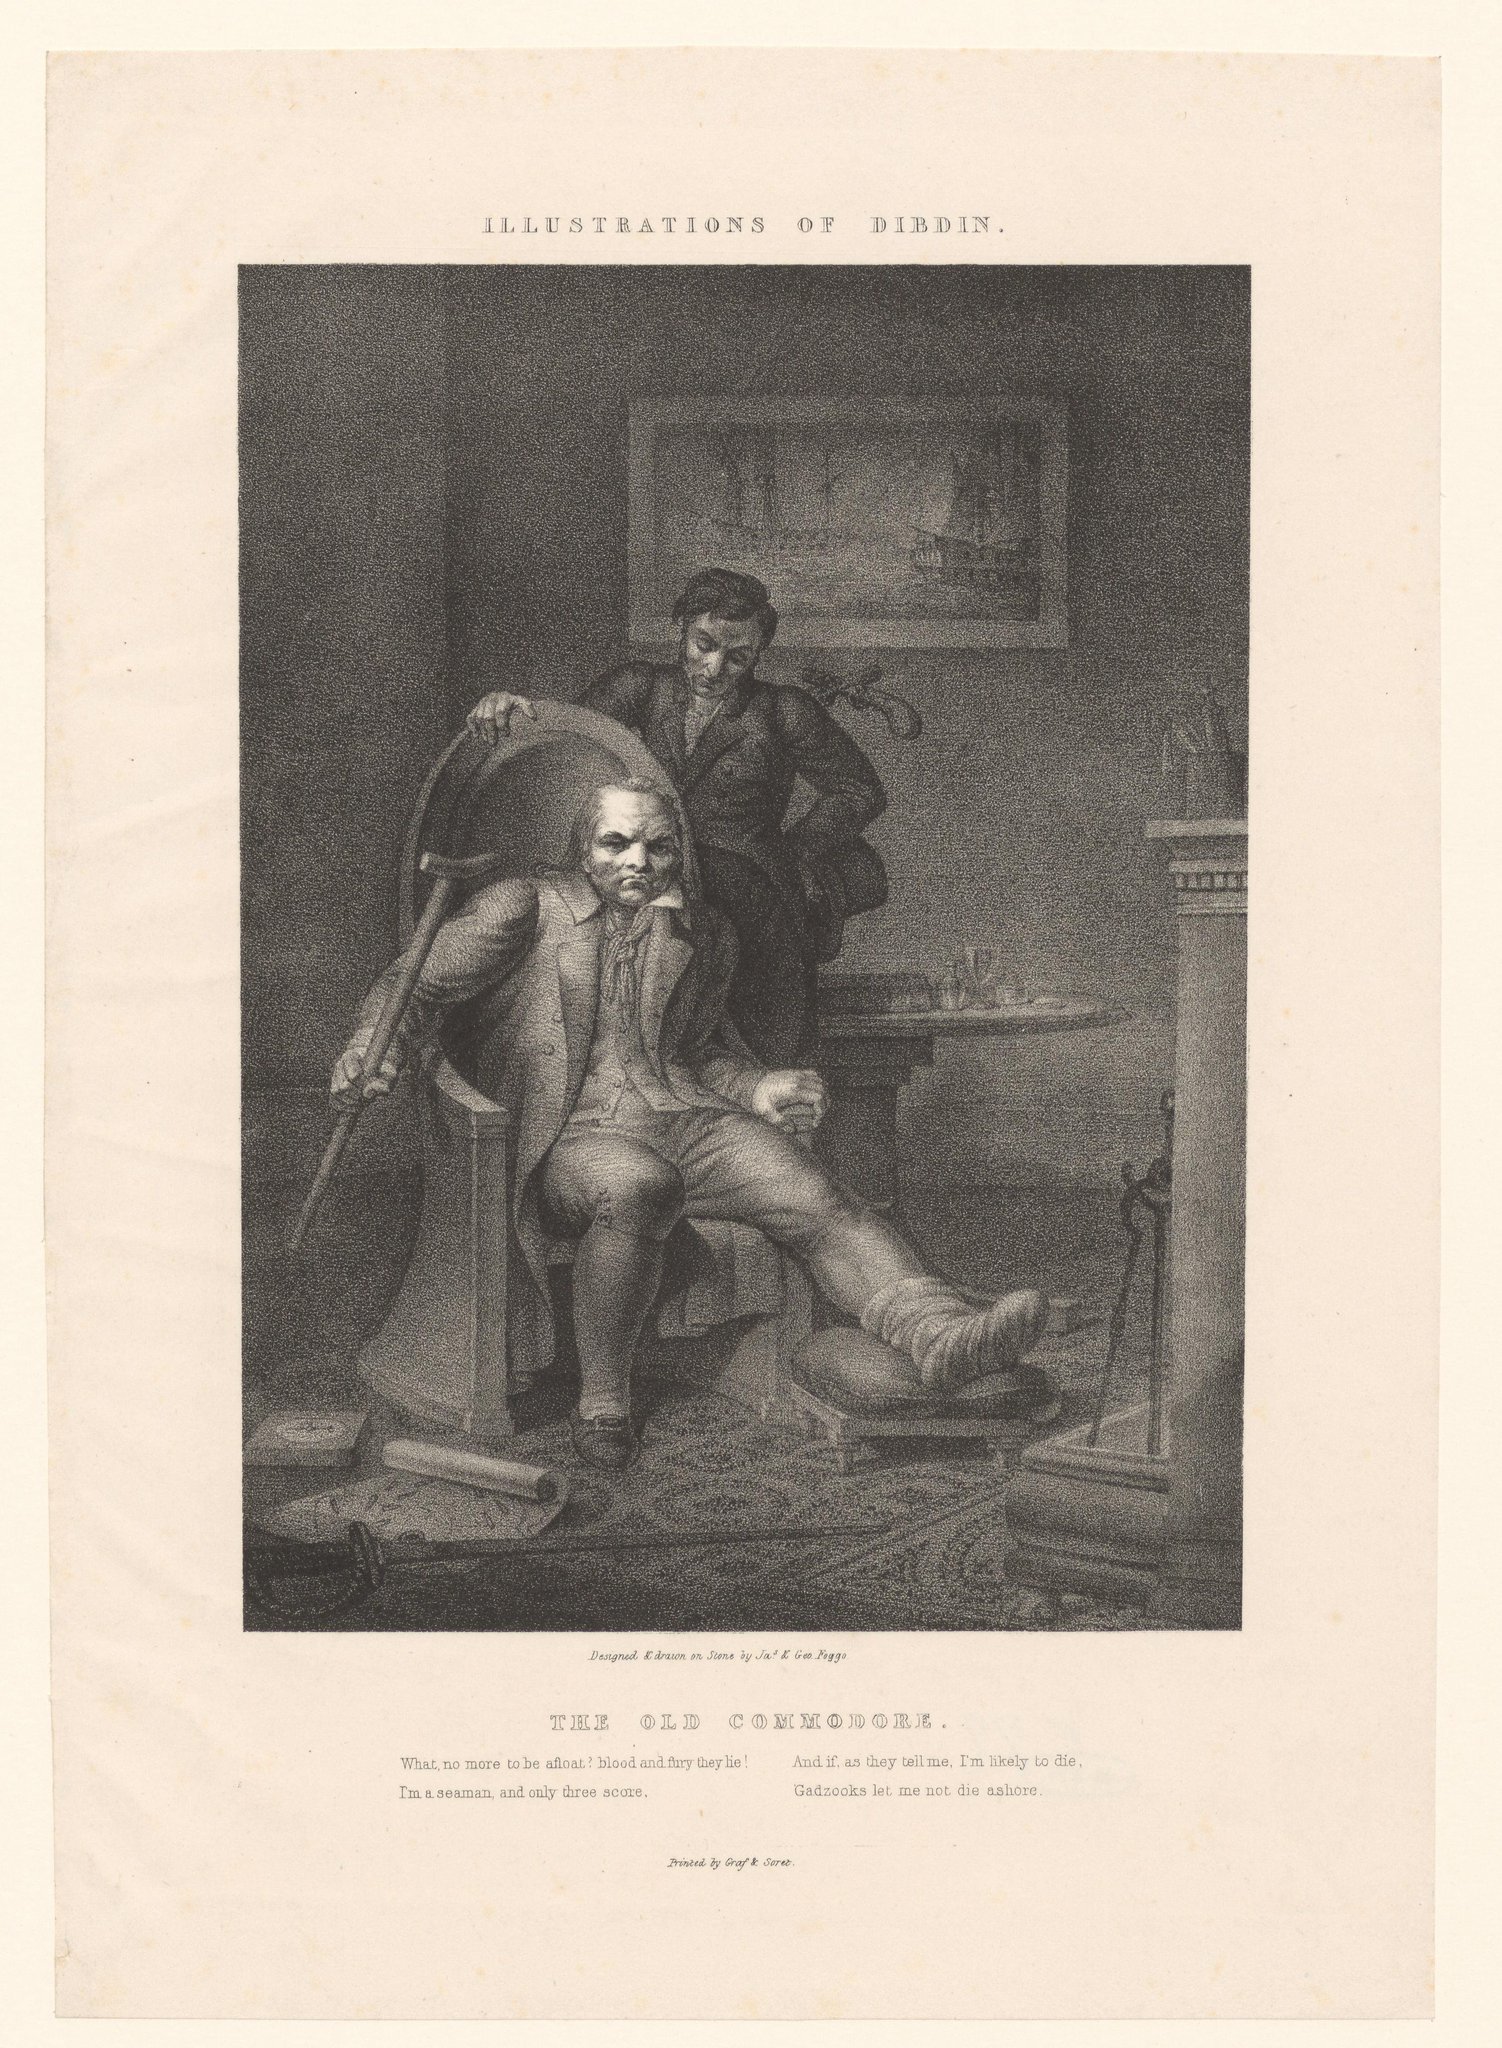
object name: print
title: Illustraties bij Dibdin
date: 1830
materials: paper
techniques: lithograph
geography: london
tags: disabled soldier, chair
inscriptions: collector's mark: Lugt 2228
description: De voorstelling illustreert een stuk van de schrijver Charles Dibdin. Met tweeregelig onderschrift.